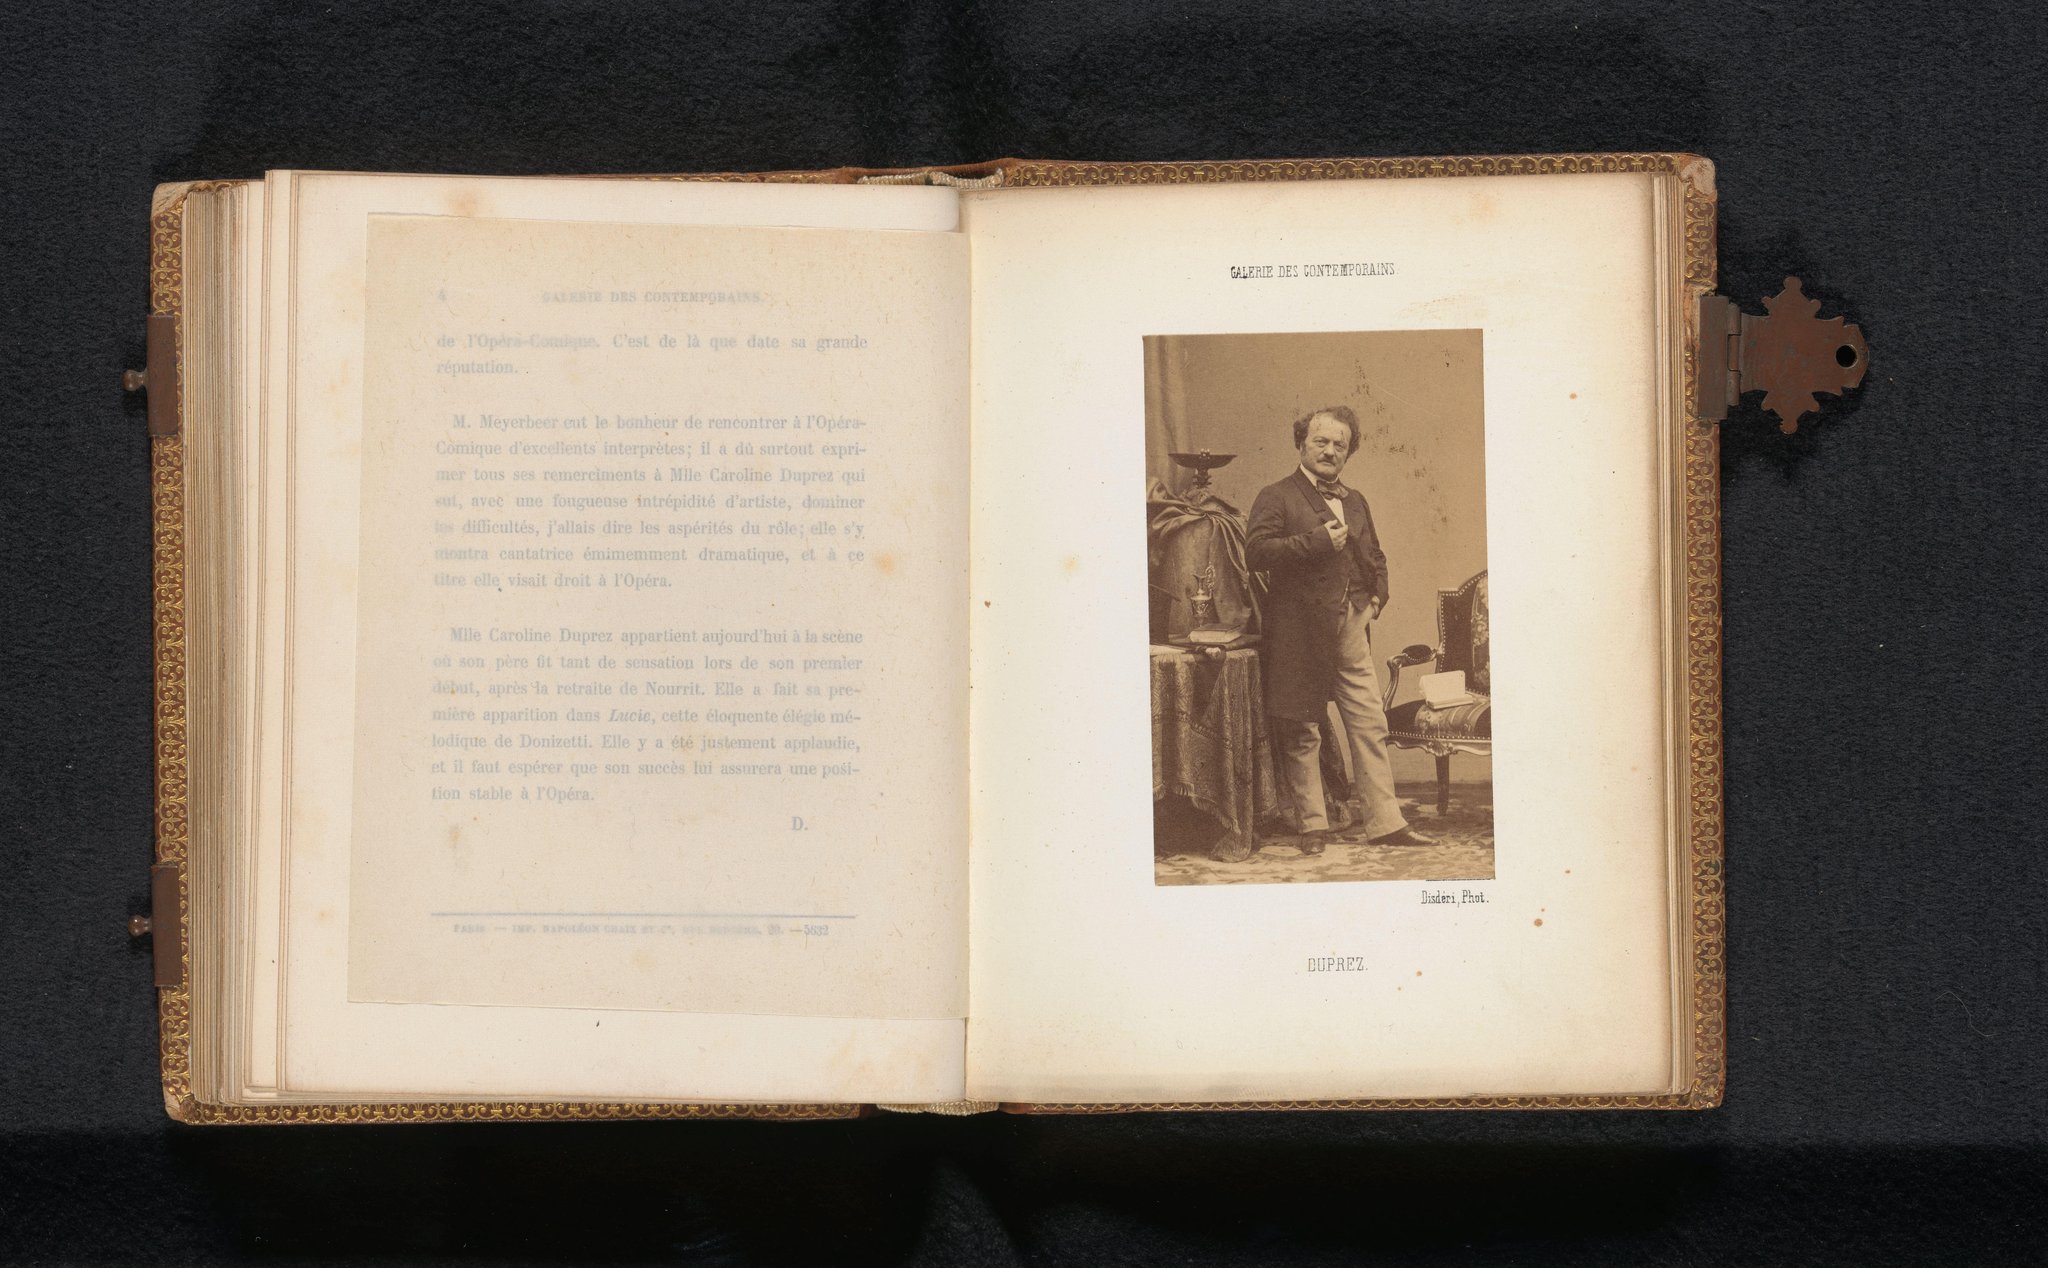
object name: page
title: Portret van Gilbert Duprez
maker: andré-adolphe-eugène disdéri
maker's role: fotograaf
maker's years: 1819-1889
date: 1857-1862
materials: photographic support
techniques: albumen print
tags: adult man, historical persons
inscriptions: inscription: ‘Galerie des Contemporains’